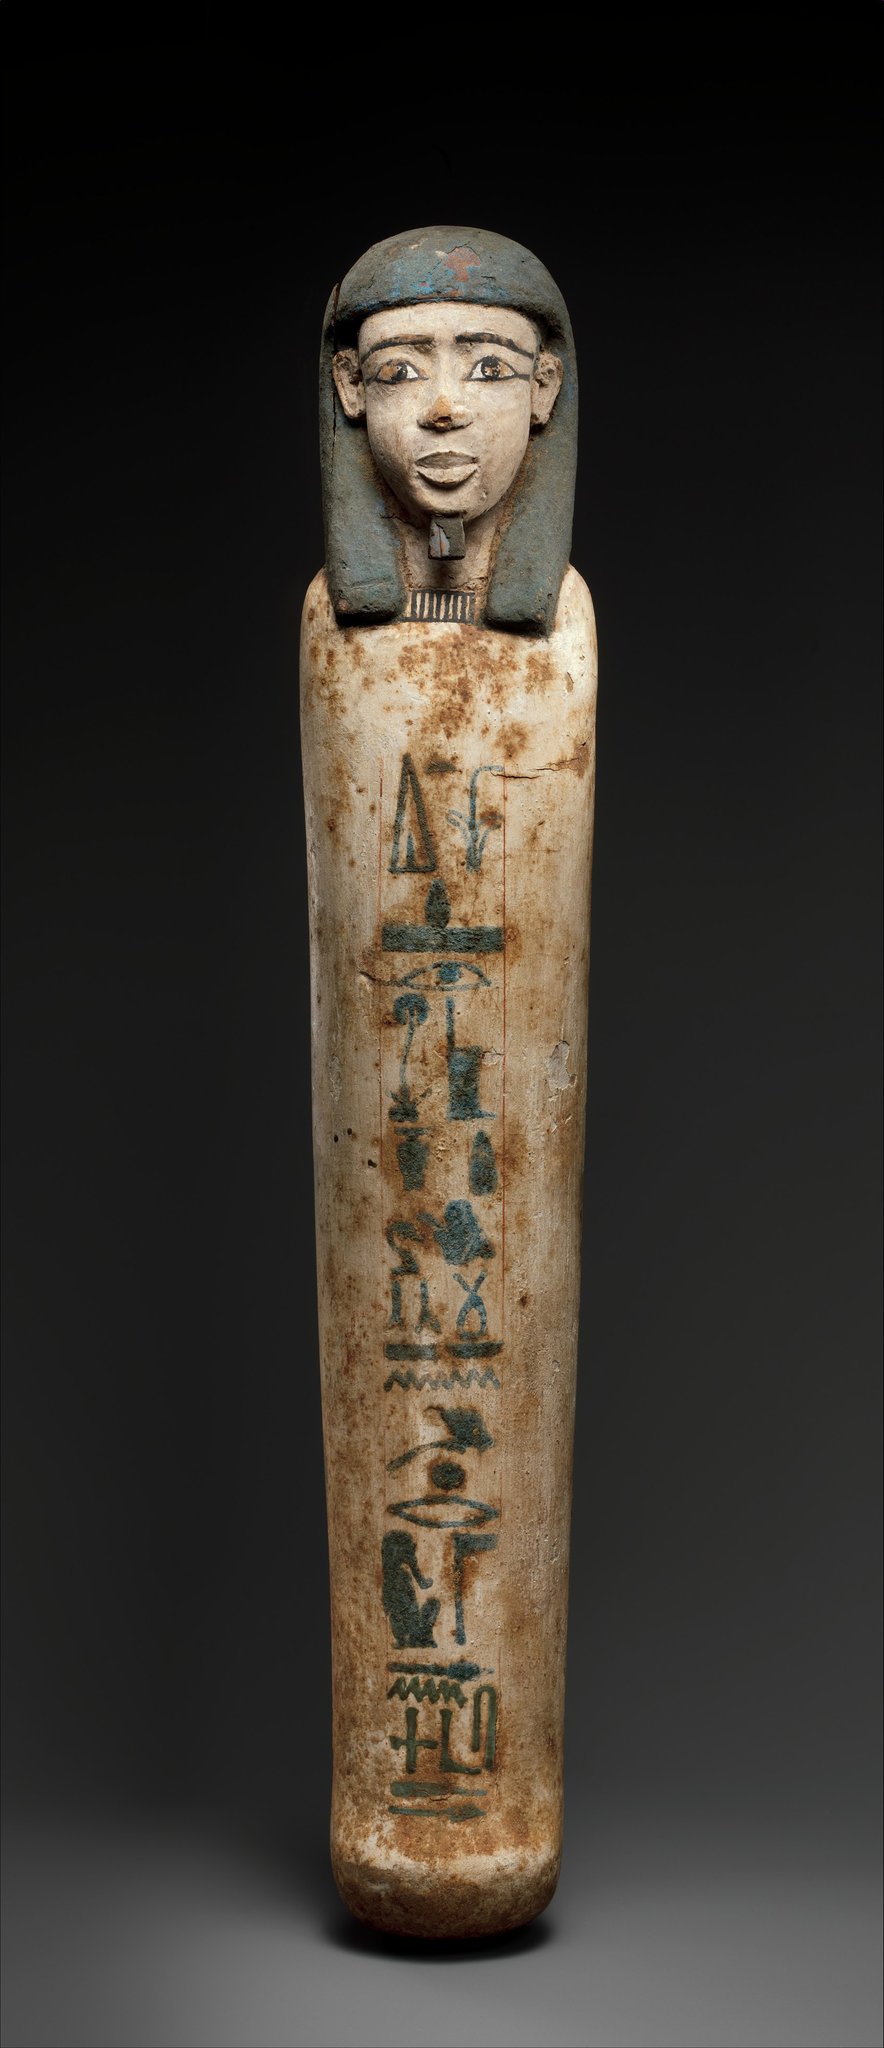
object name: shabti, senebimi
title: Shabti of Senebimi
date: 1981-1802 BCE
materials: paint, wood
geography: egypt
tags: hieroglyphs